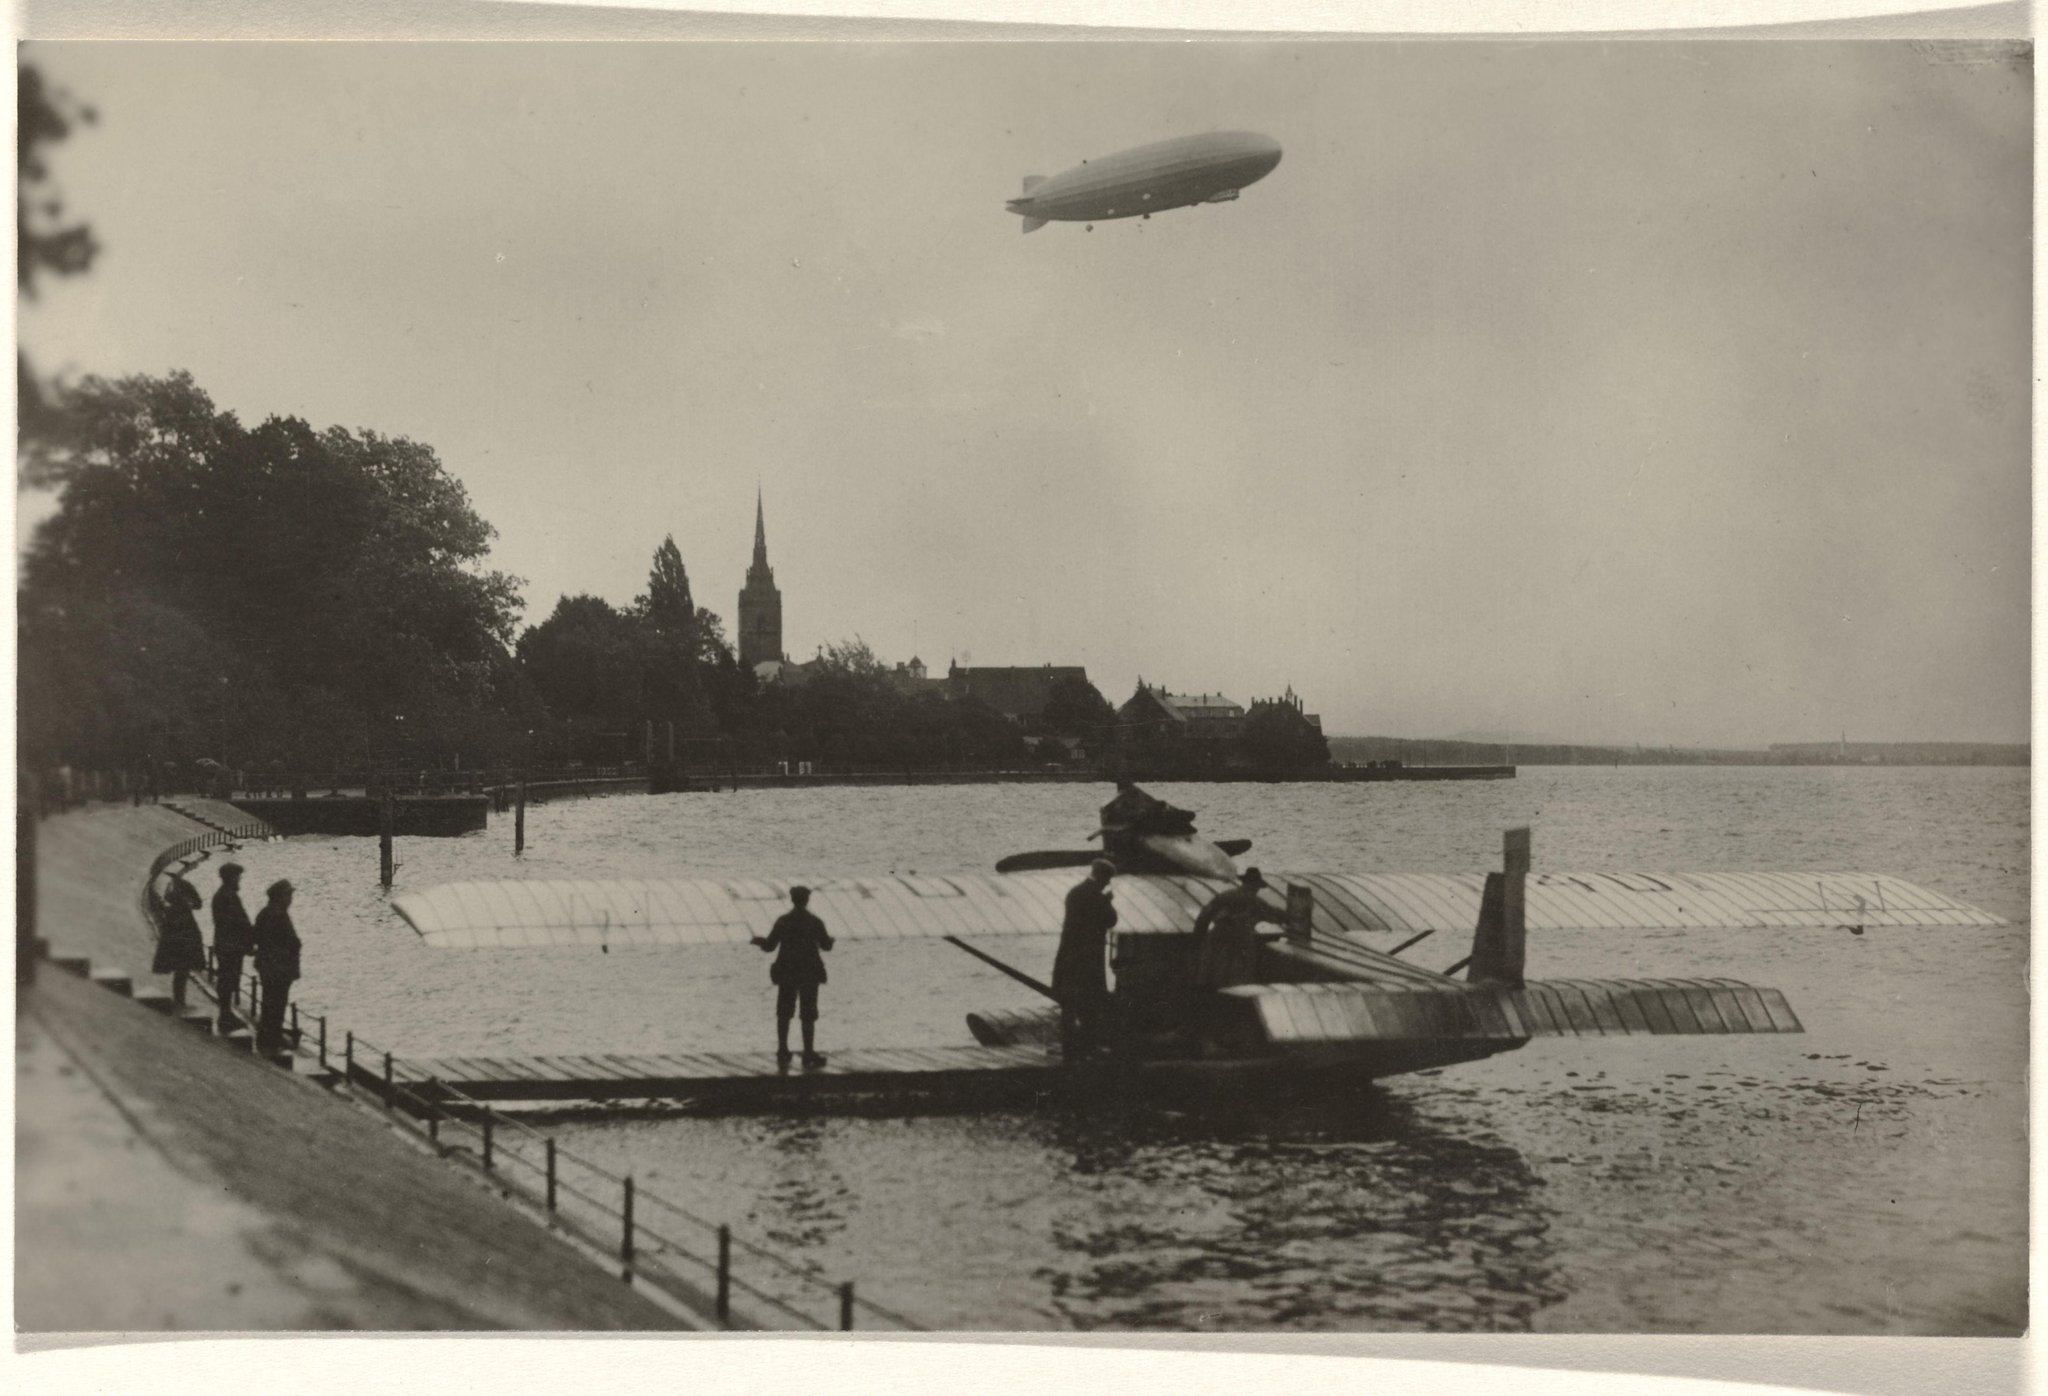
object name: photograph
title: De Amerika-zeppelin ZR 3 bij zijn eerste proefvlucht over Friedrichshafen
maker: Anonymous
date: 1924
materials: photographic support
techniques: gelatin silver print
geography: friedrichshafen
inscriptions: inscription: ‘AMERIKA-ZEPPELIN Z R III bei seiner ersten Probefahrt über Friedrichshafen am 27.8.24 (Aufgenommen von Prof. Maerker, Konstanz).’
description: Watervliegtuig in een meer met mensen op het vliegtuig en op de kant, met een zeppelin in de lucht en een spitse toren op de achtergrond.